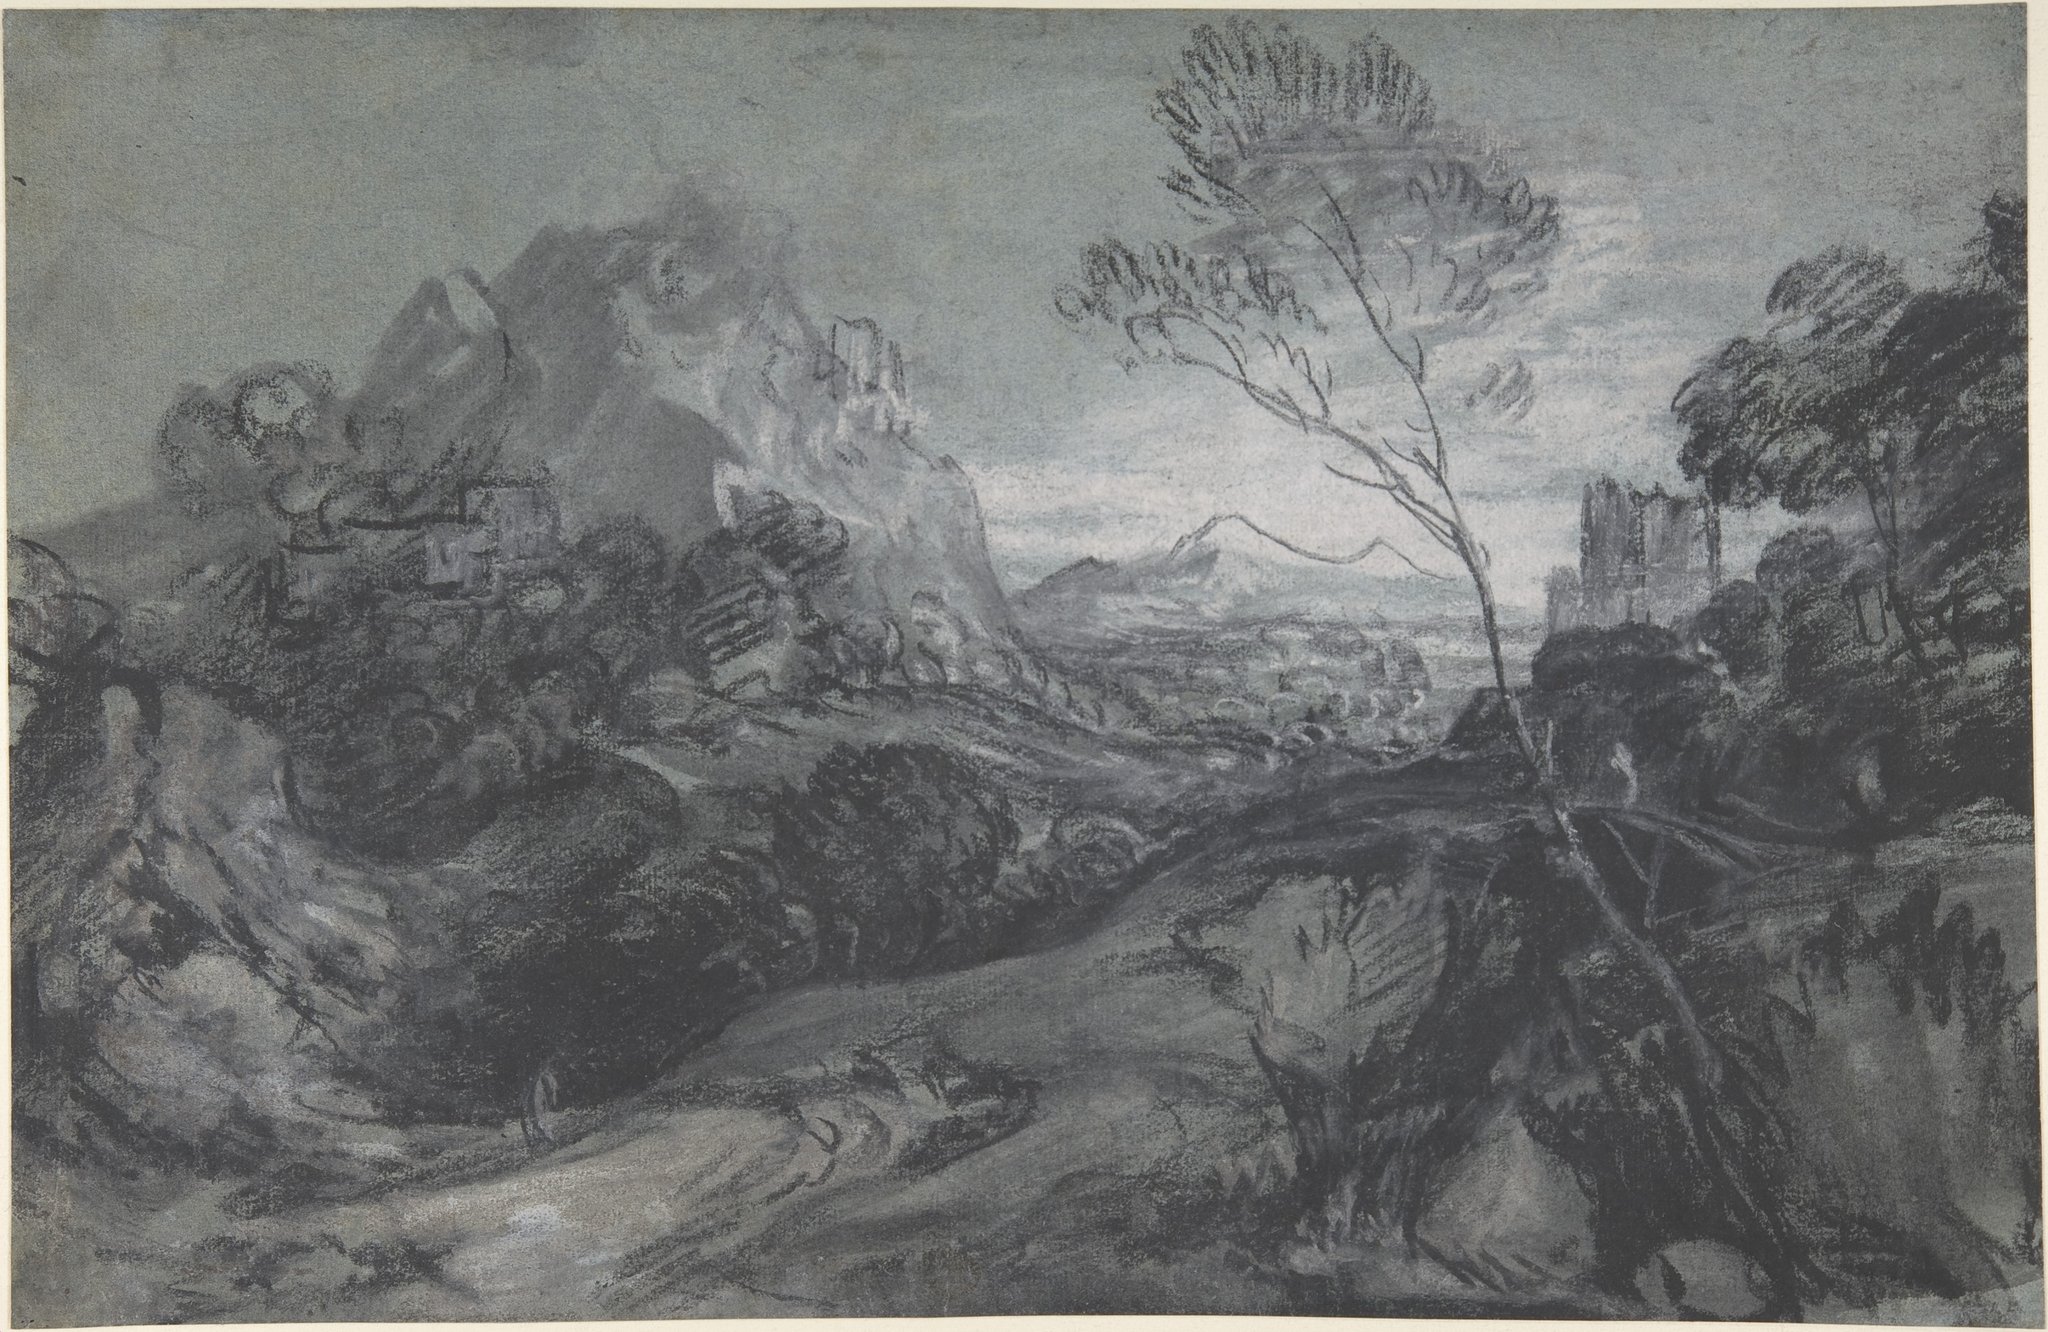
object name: drawing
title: Mountain Landscape with Figures and Buildings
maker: thomas gainsborough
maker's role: artist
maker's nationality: british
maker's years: 1727-1788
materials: chalk, paper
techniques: stumping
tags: buildings,mountains,landscapes